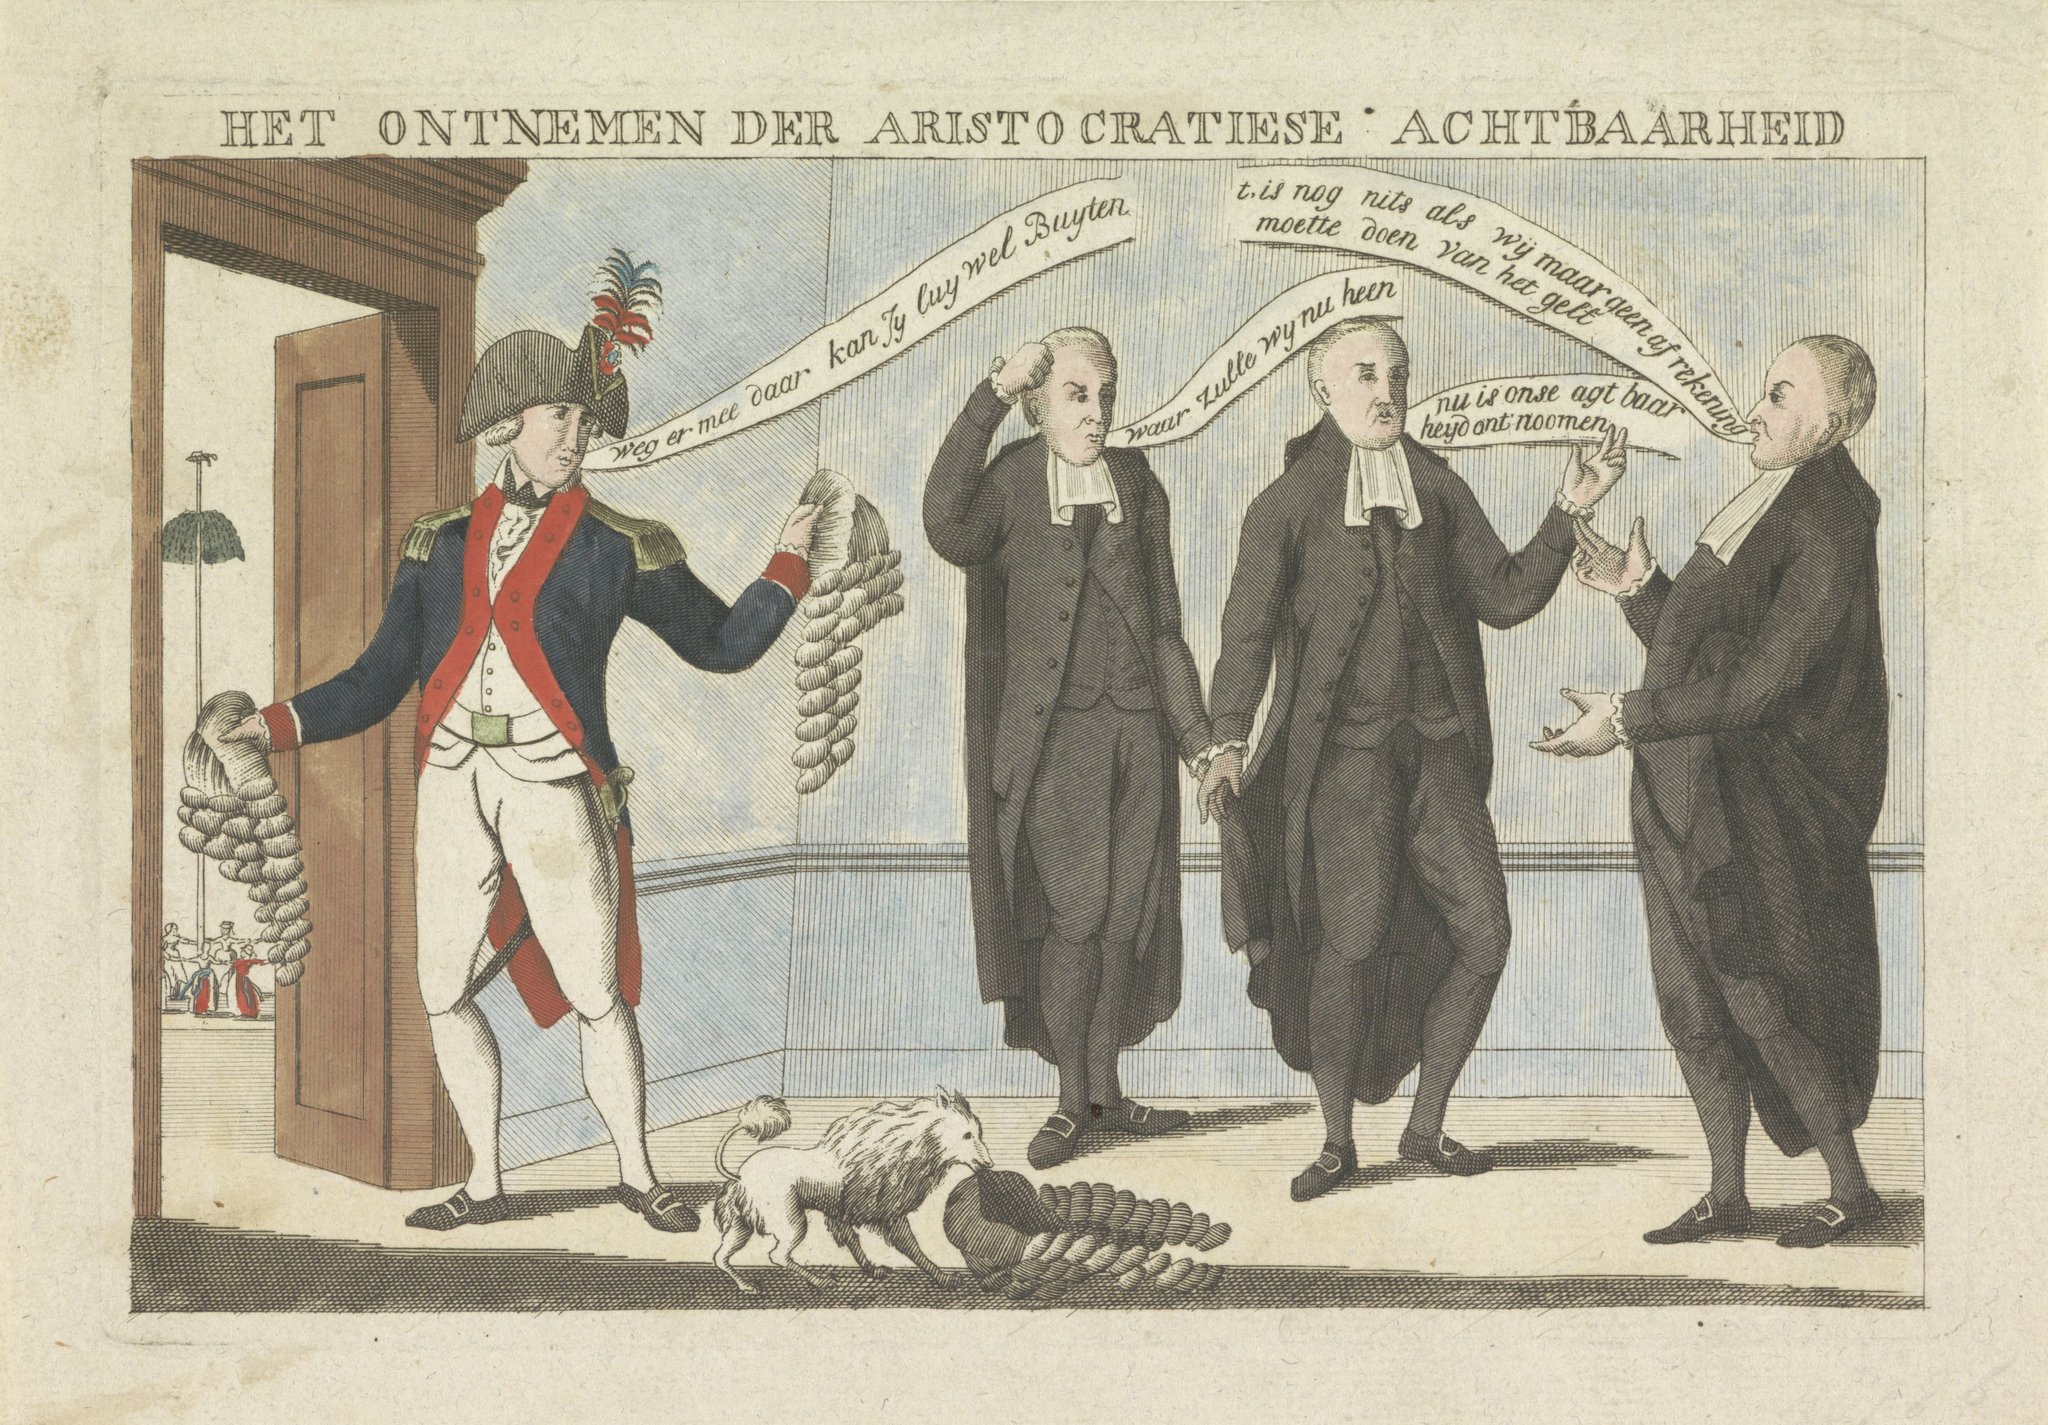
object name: print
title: Spotprent op de Aristocratie (1), 1795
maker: Anonymous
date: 1795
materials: paper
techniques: etching, hand coloring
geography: netherlands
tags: aristocracy; 'aristocratia' (ripa), wig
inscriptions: collector's mark: Lugt 2228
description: Spotprent op de Aristocratie, 1795. Een Franse soldaat ontneemt drie mannen (predikanten?) hun pruiken en loopt ermee naar een deur. Een keeshond sleept een pruik over de grond weg. De mannen klagen dat nu hun achtbaarheid hen is ontnomen. Door de deuropening zicht op het dansen om de vrijheidsboom. Zie ook pendant.